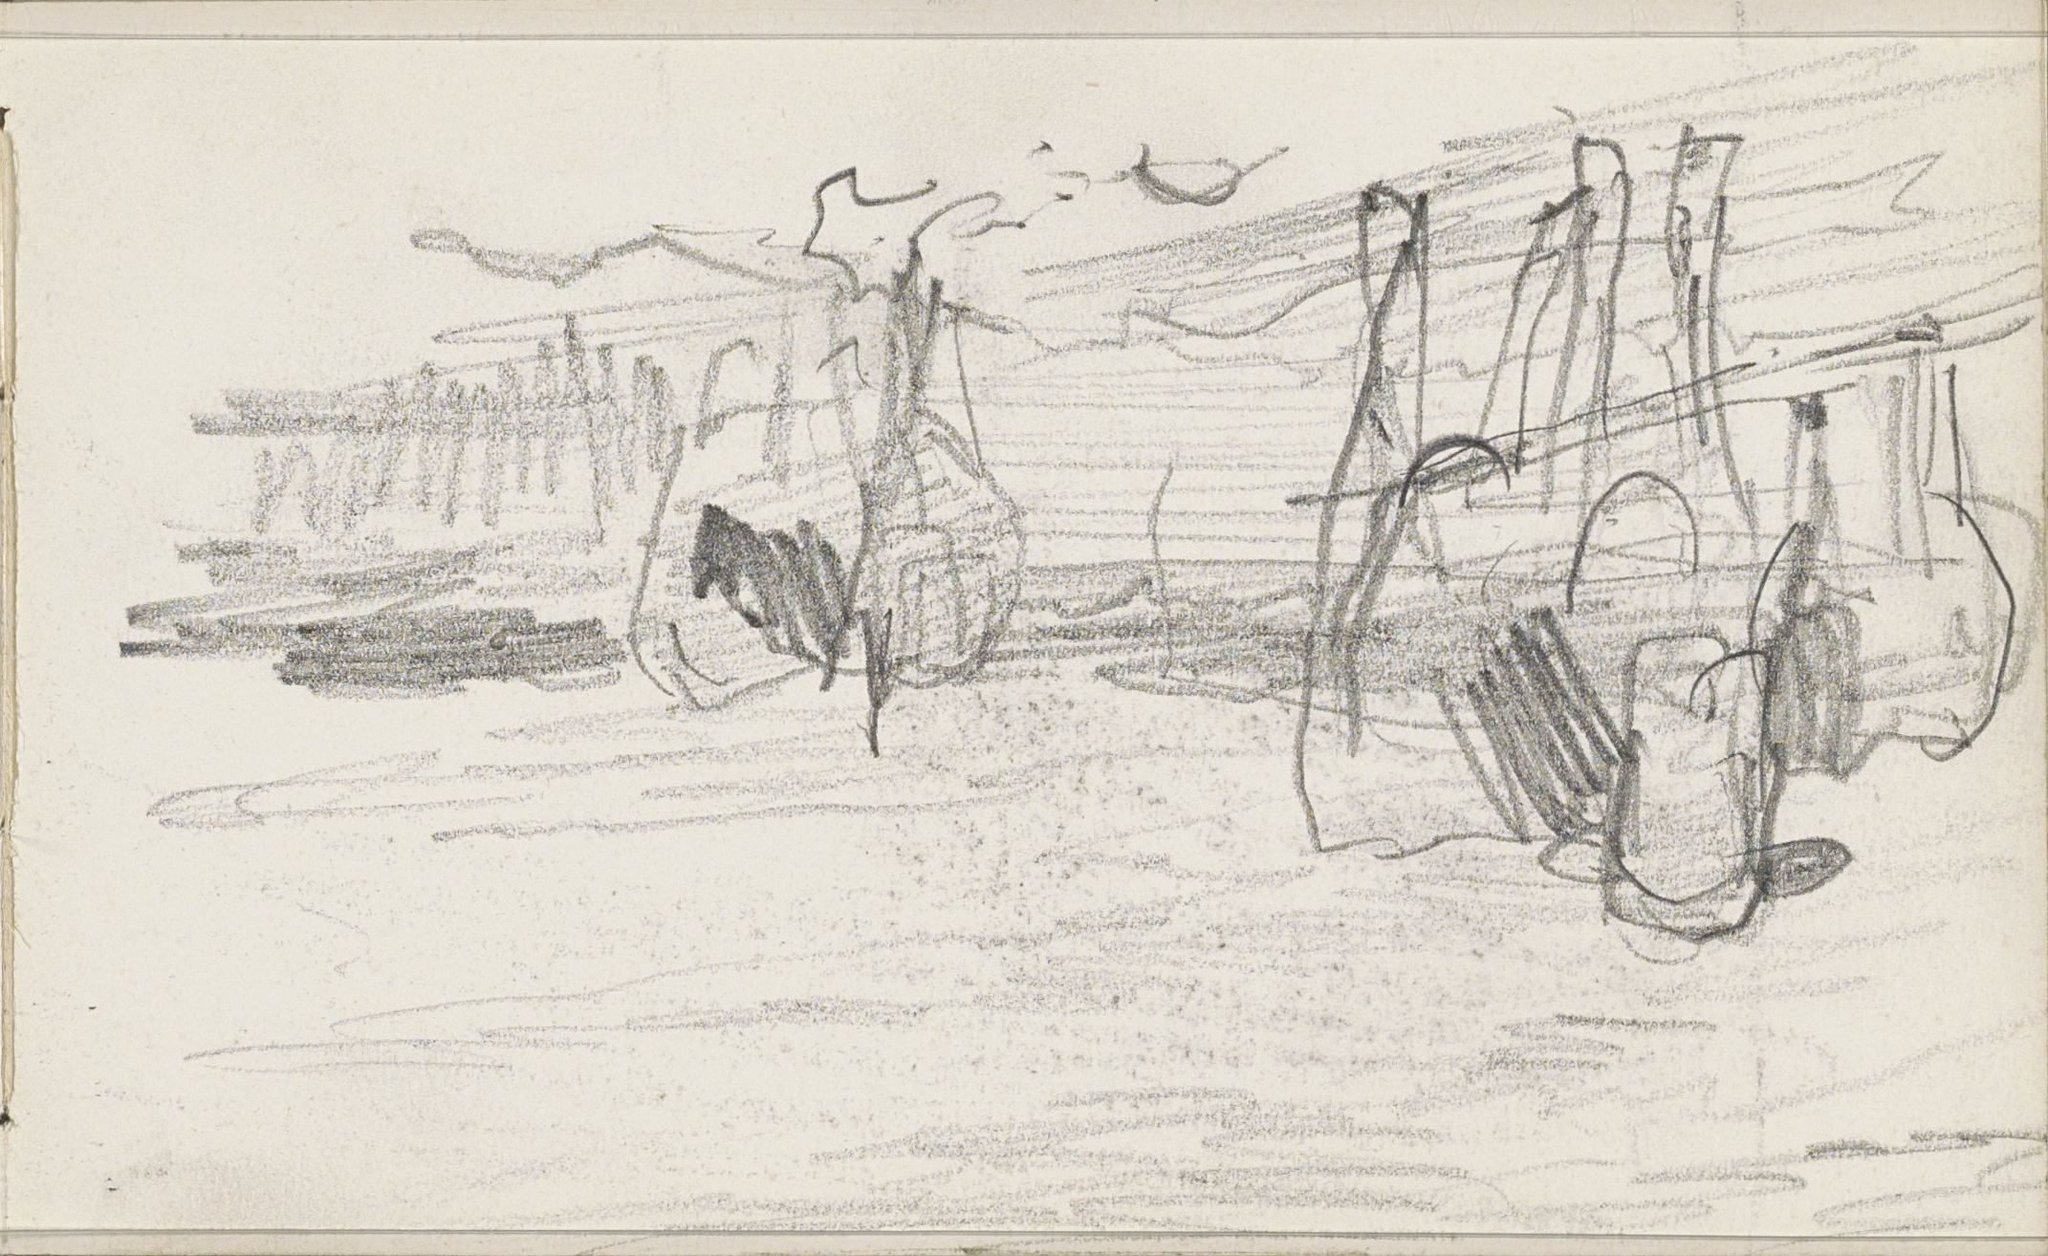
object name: sketchbook leaf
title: Koeien in een weide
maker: anton mauve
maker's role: draughtsman, painter, print maker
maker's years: 1838-1888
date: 1848-1888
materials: paper, pencil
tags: cow, meadow, pasture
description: Blad 31 recto uit een schetsboek met 43 bladen.